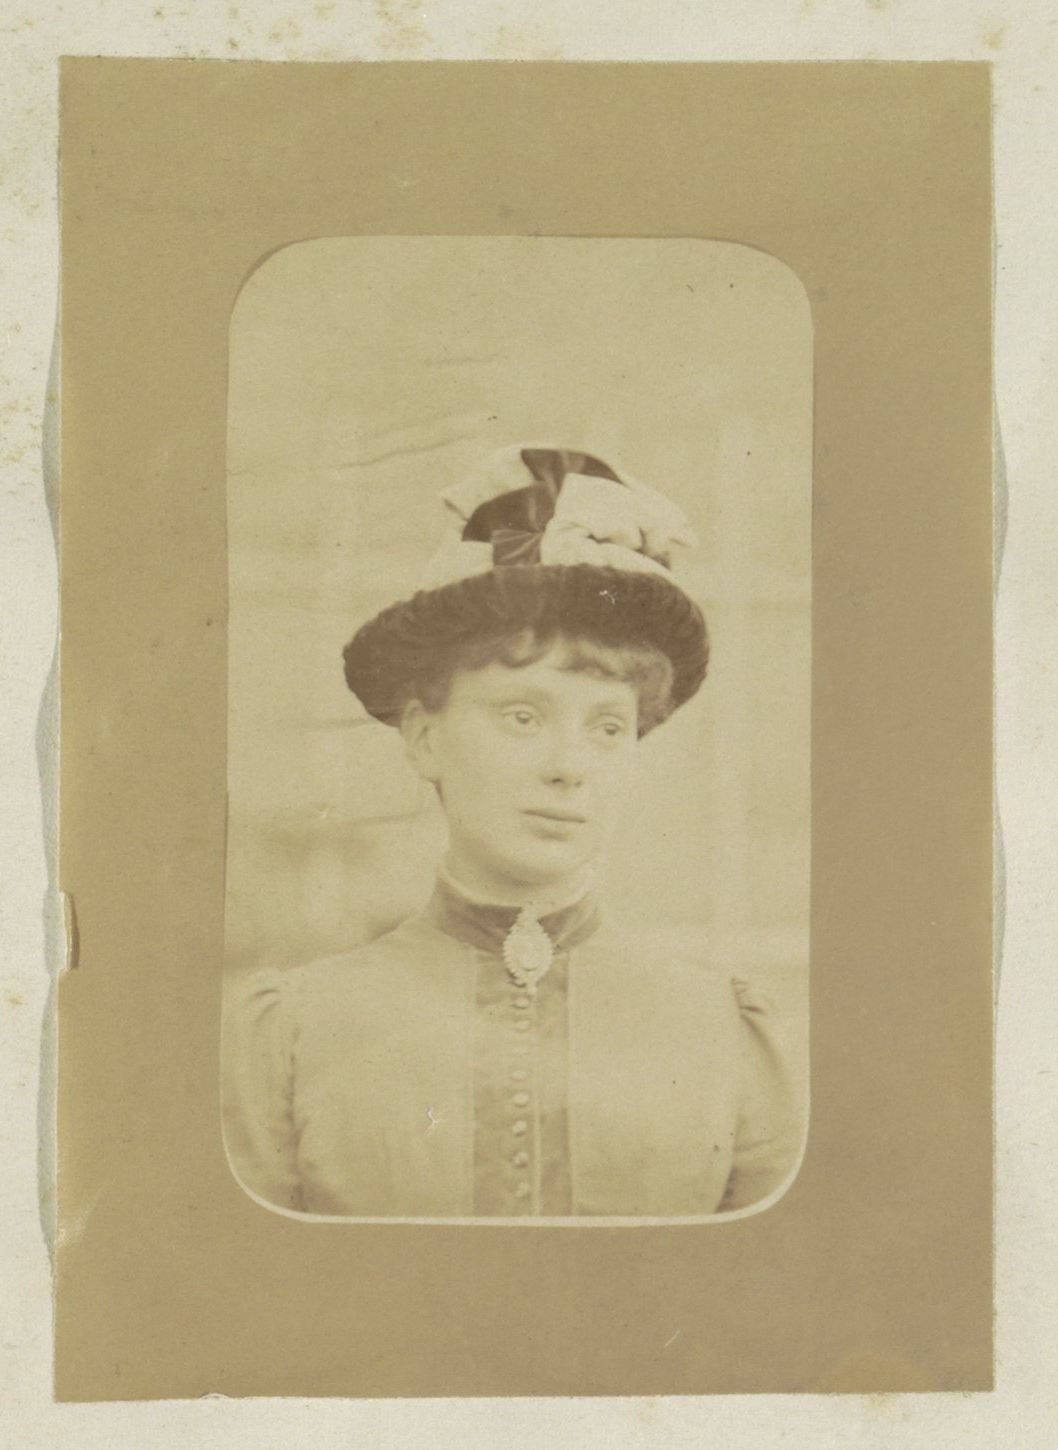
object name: photograph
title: Portret van een onbekende Française met hoed en halssieraad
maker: Anonymous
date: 1883-1886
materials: photographic support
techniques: albumen print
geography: france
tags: adult woman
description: Onderdeel van Album van een Franse amateurfotograaf met opnames van familie, militairen, industrie, landschappen en bezienswaardigheden in Frankrijk.